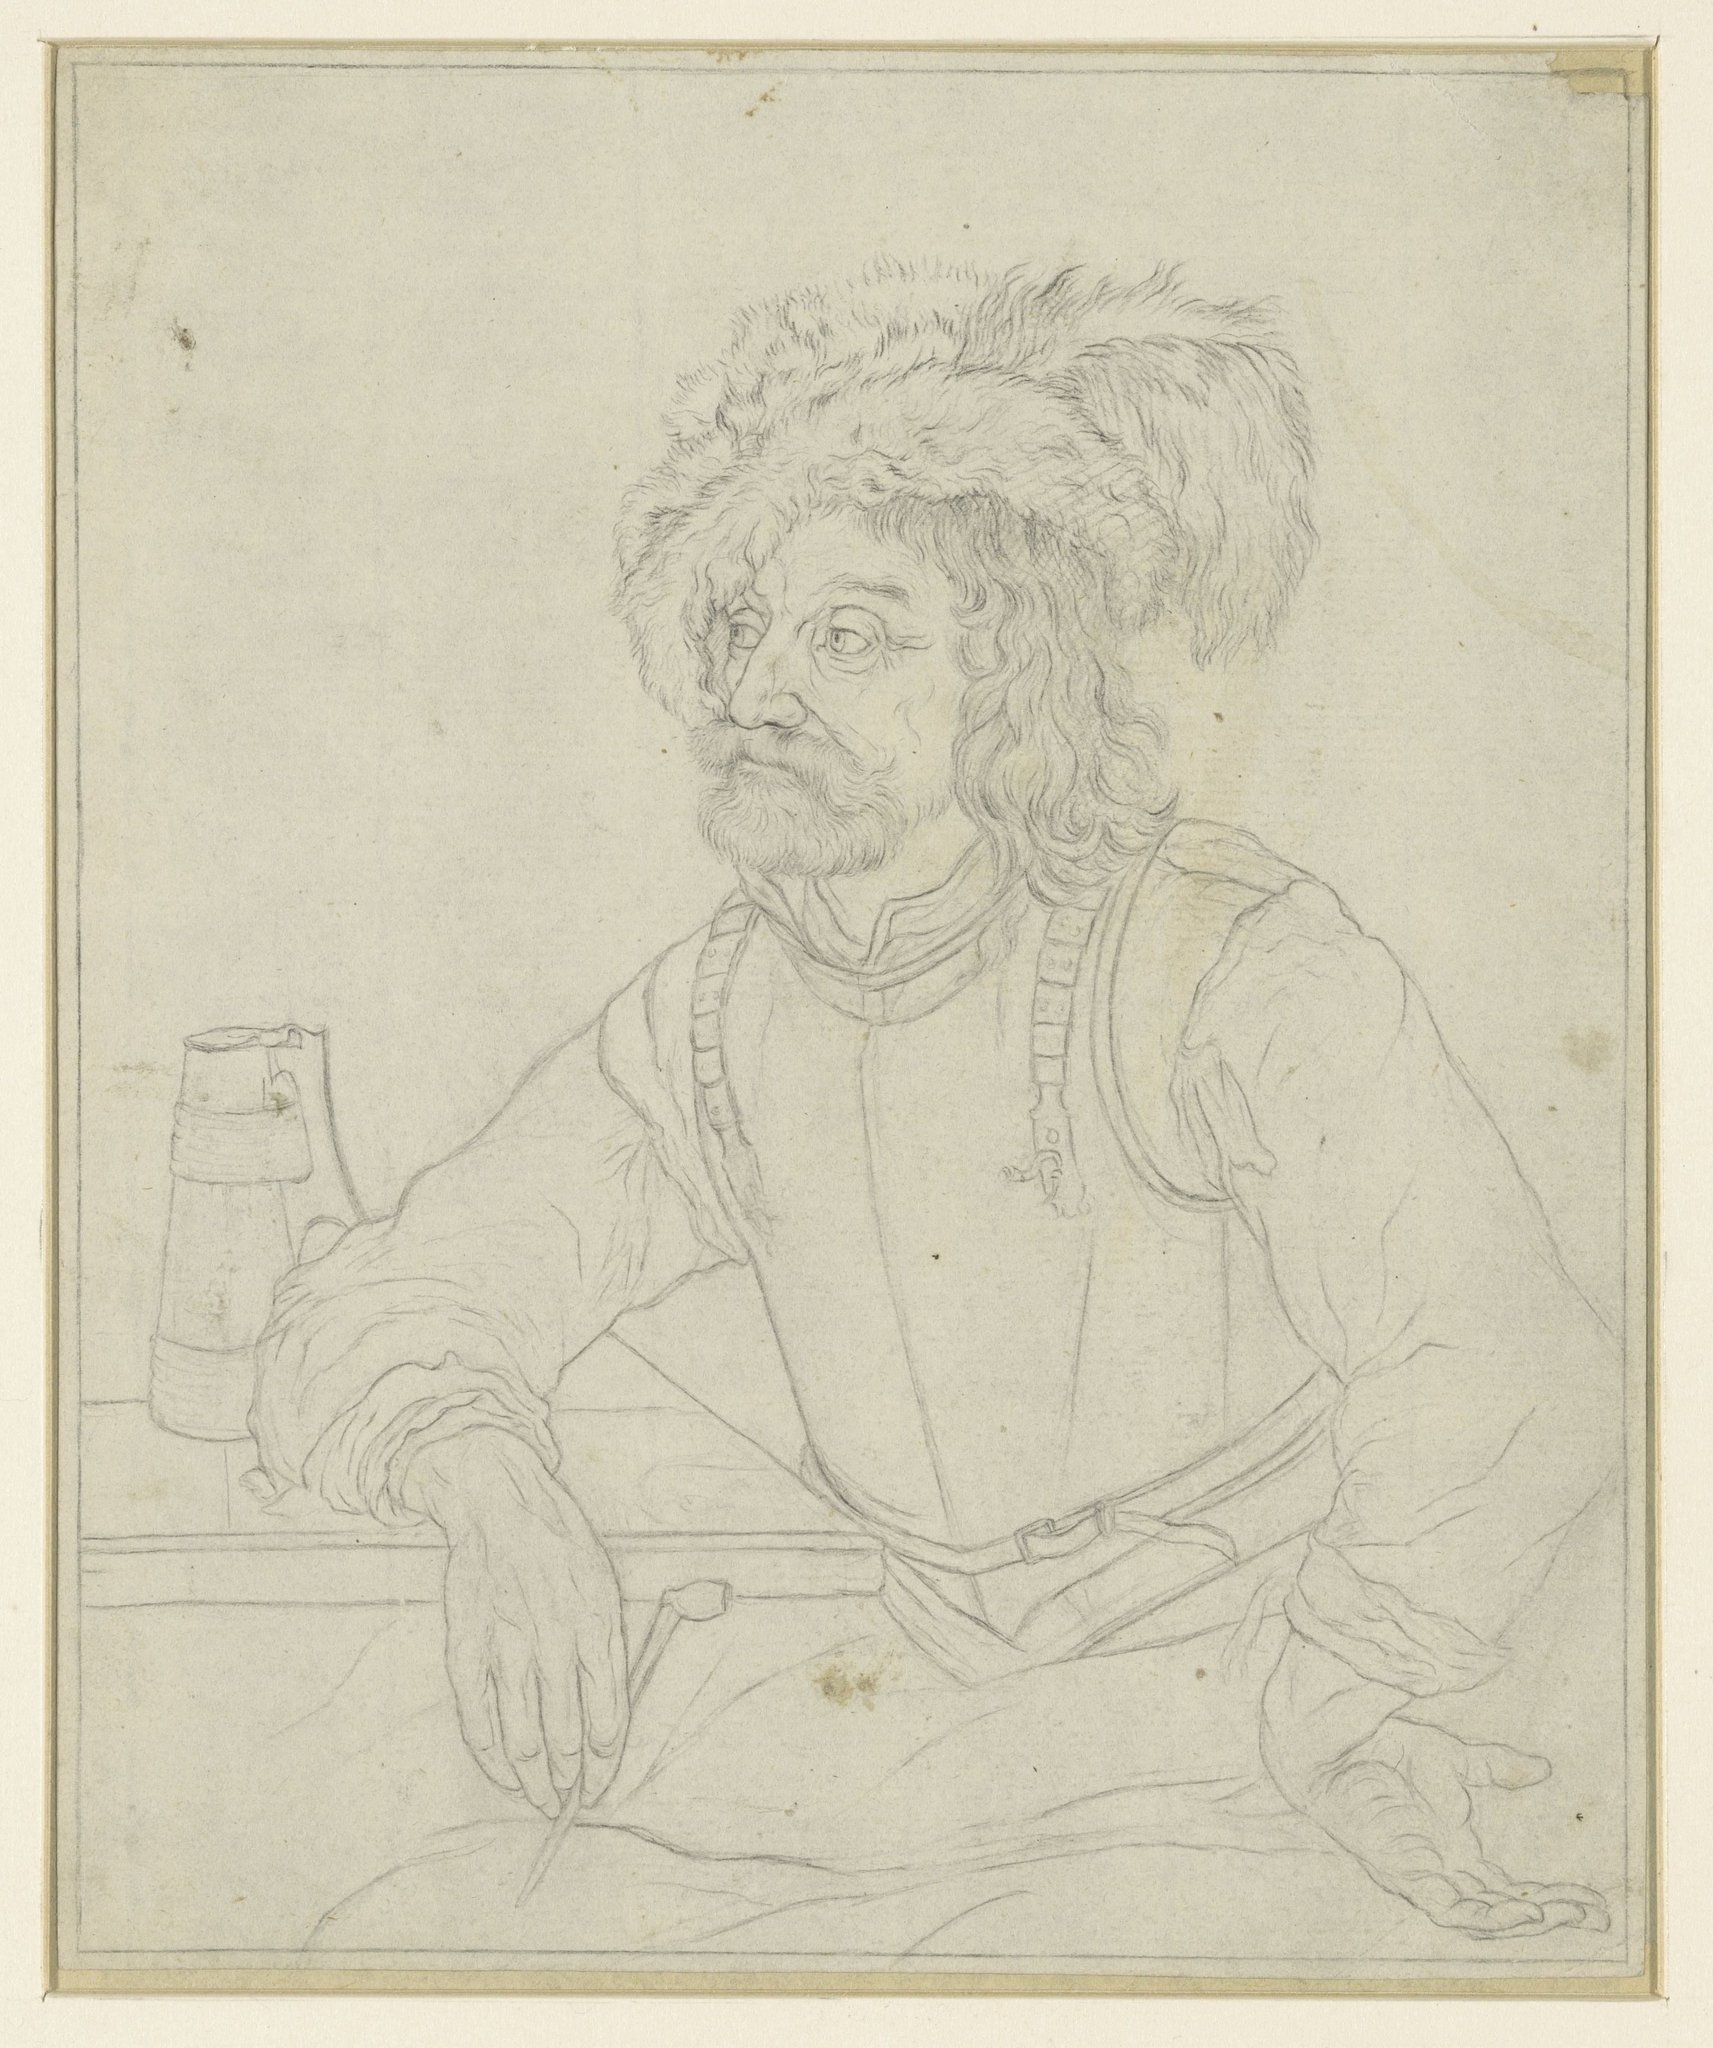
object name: drawing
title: Krijgsman aan tafel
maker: johann nepomuk strixner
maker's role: draughtsman, print maker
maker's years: 1782-1855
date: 1819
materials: paper, pencil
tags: inn, coffee-house, public house, etc., recreation ~ the soldier off duty